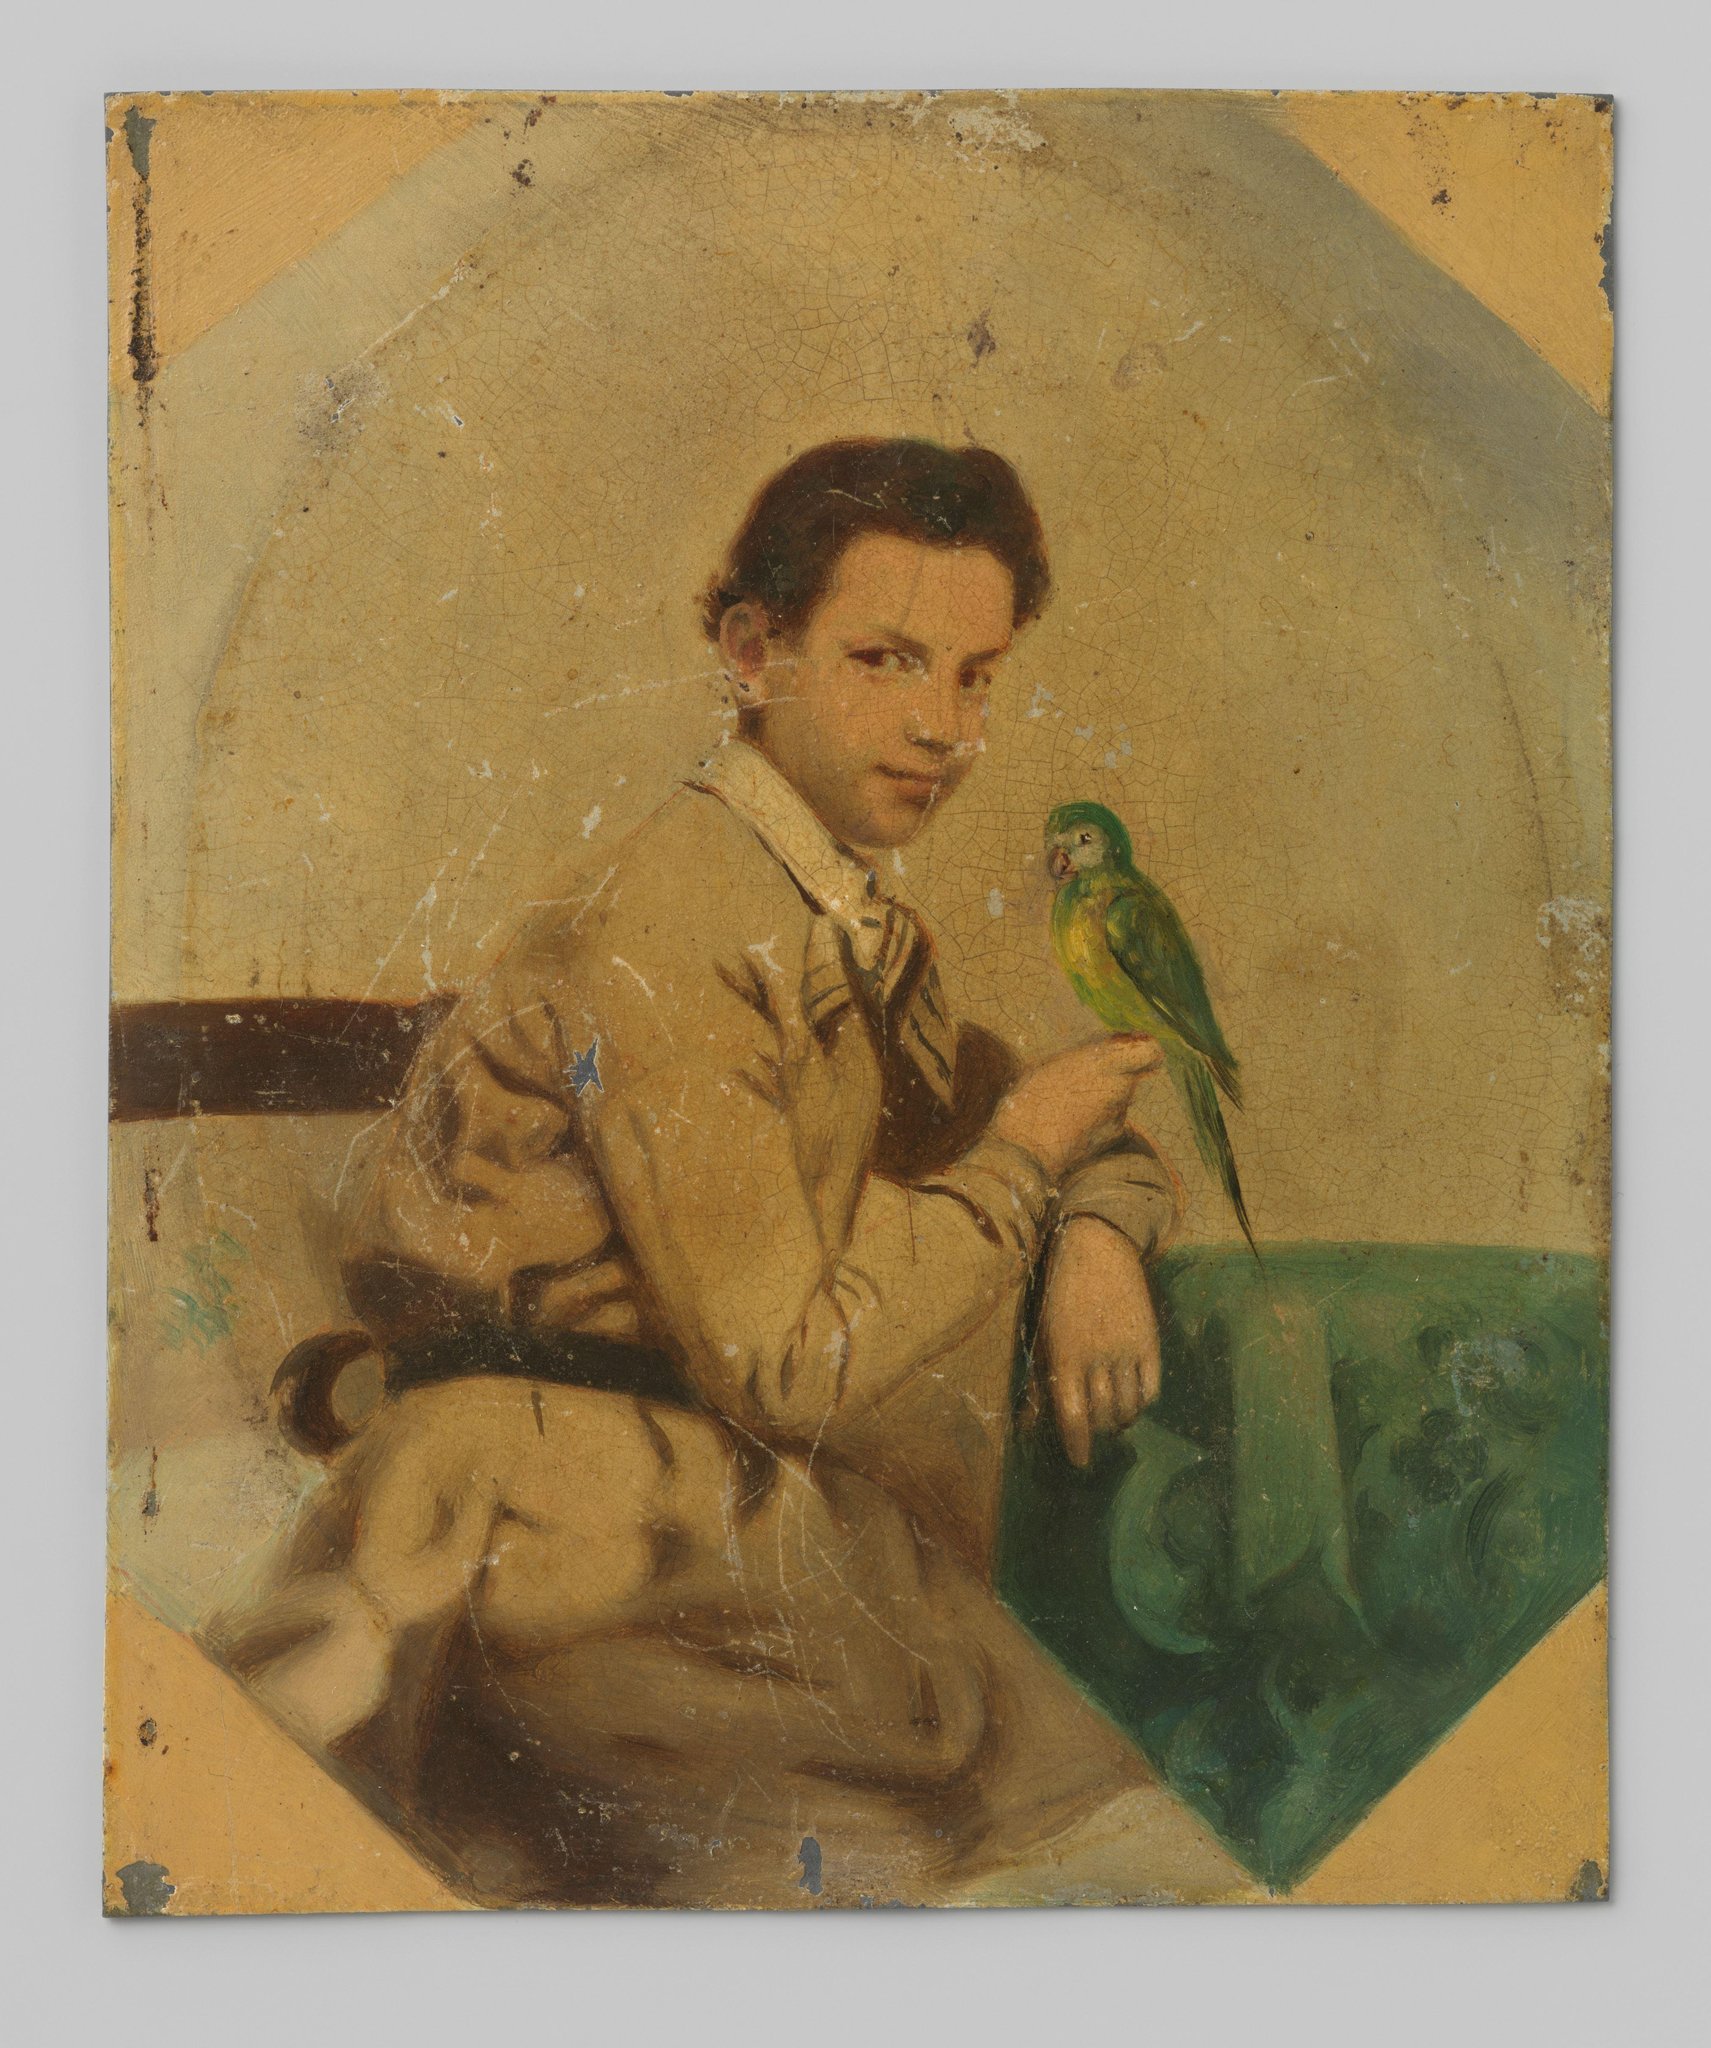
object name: frame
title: Portret van een onbekende jongen met een vogel, mogelijk een parkiet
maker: Anonymous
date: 1870-1910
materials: metal, paint, paper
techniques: albumen print, hand coloring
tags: birds (+ man and animal), boy (child between toddler and youth), historical persons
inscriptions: inscription: ‘35,=/ 2’